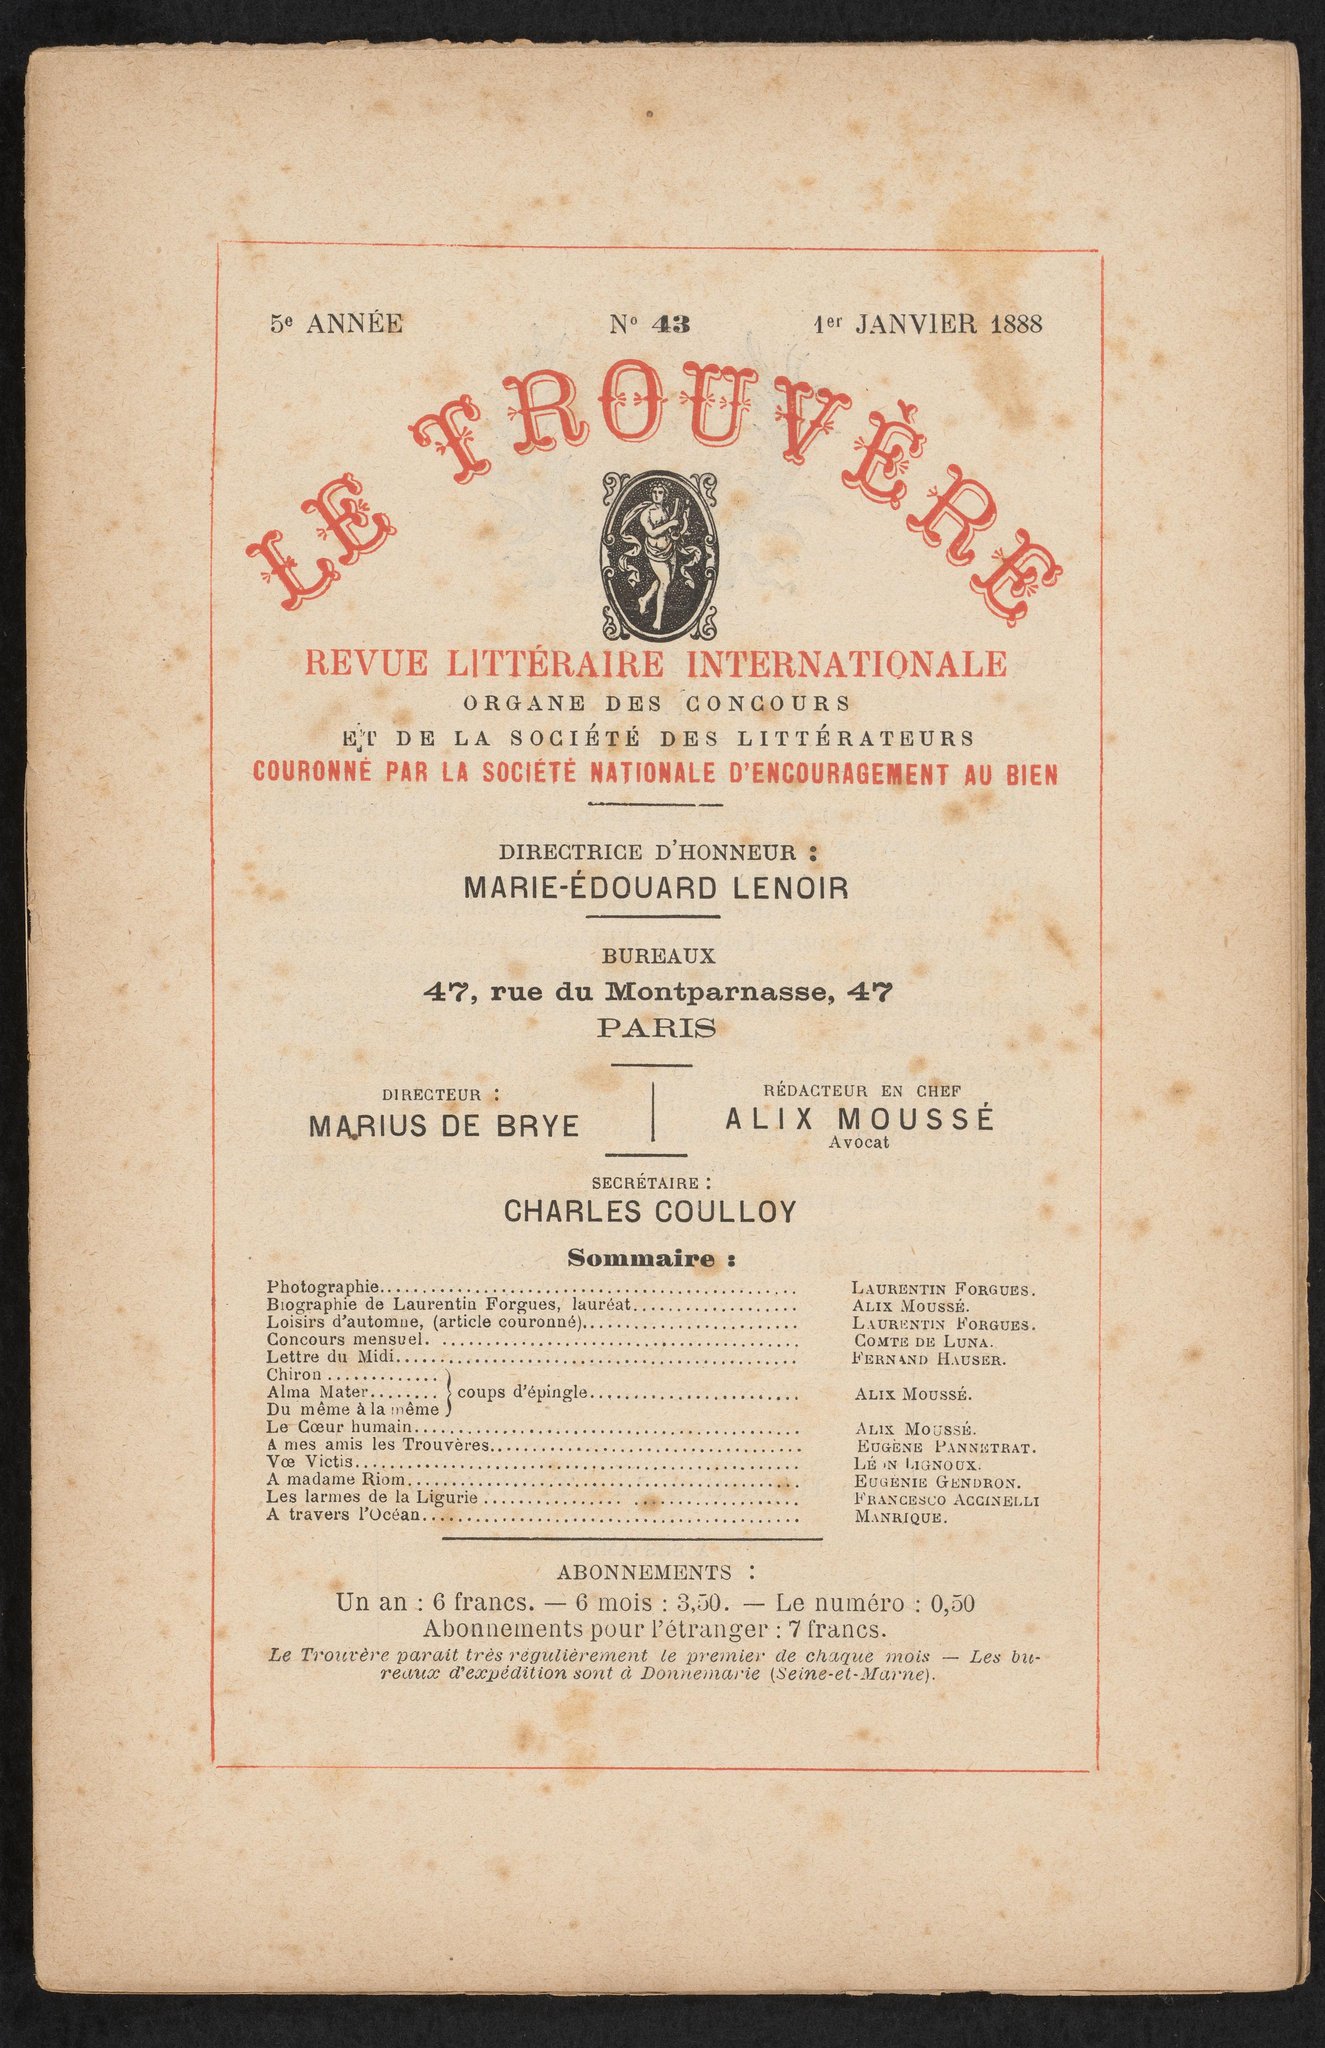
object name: book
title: Le trouvère No 43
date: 1801-1888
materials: paper, photographic support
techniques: albumen print, printing, engraving